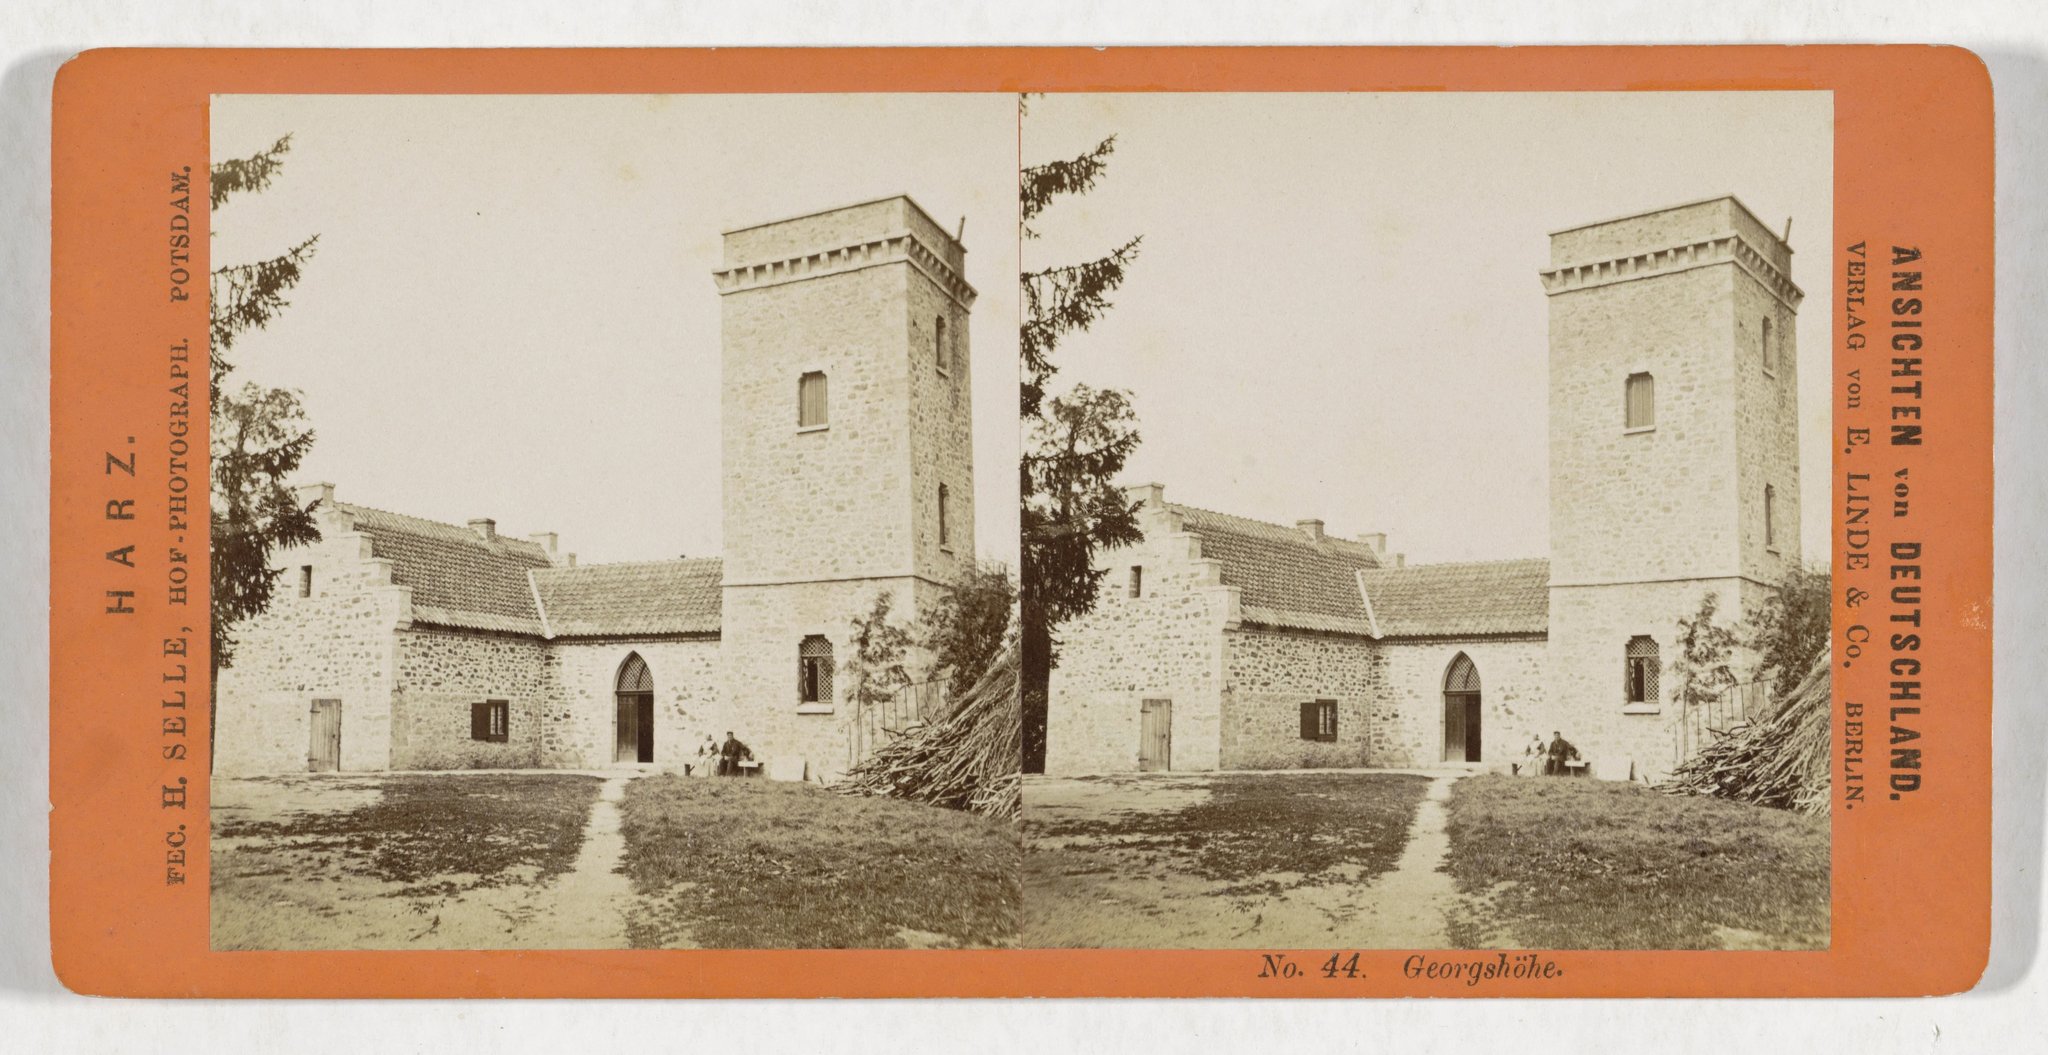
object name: stereograph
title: Georgshöhe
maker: hermann selle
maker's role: fotograaf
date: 1868-1890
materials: cardboard, paper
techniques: albumen print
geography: georgshöhe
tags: forestry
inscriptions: number: ‘No. 44.’, inscription: ‘Hof-Photograph. Potsdam.’